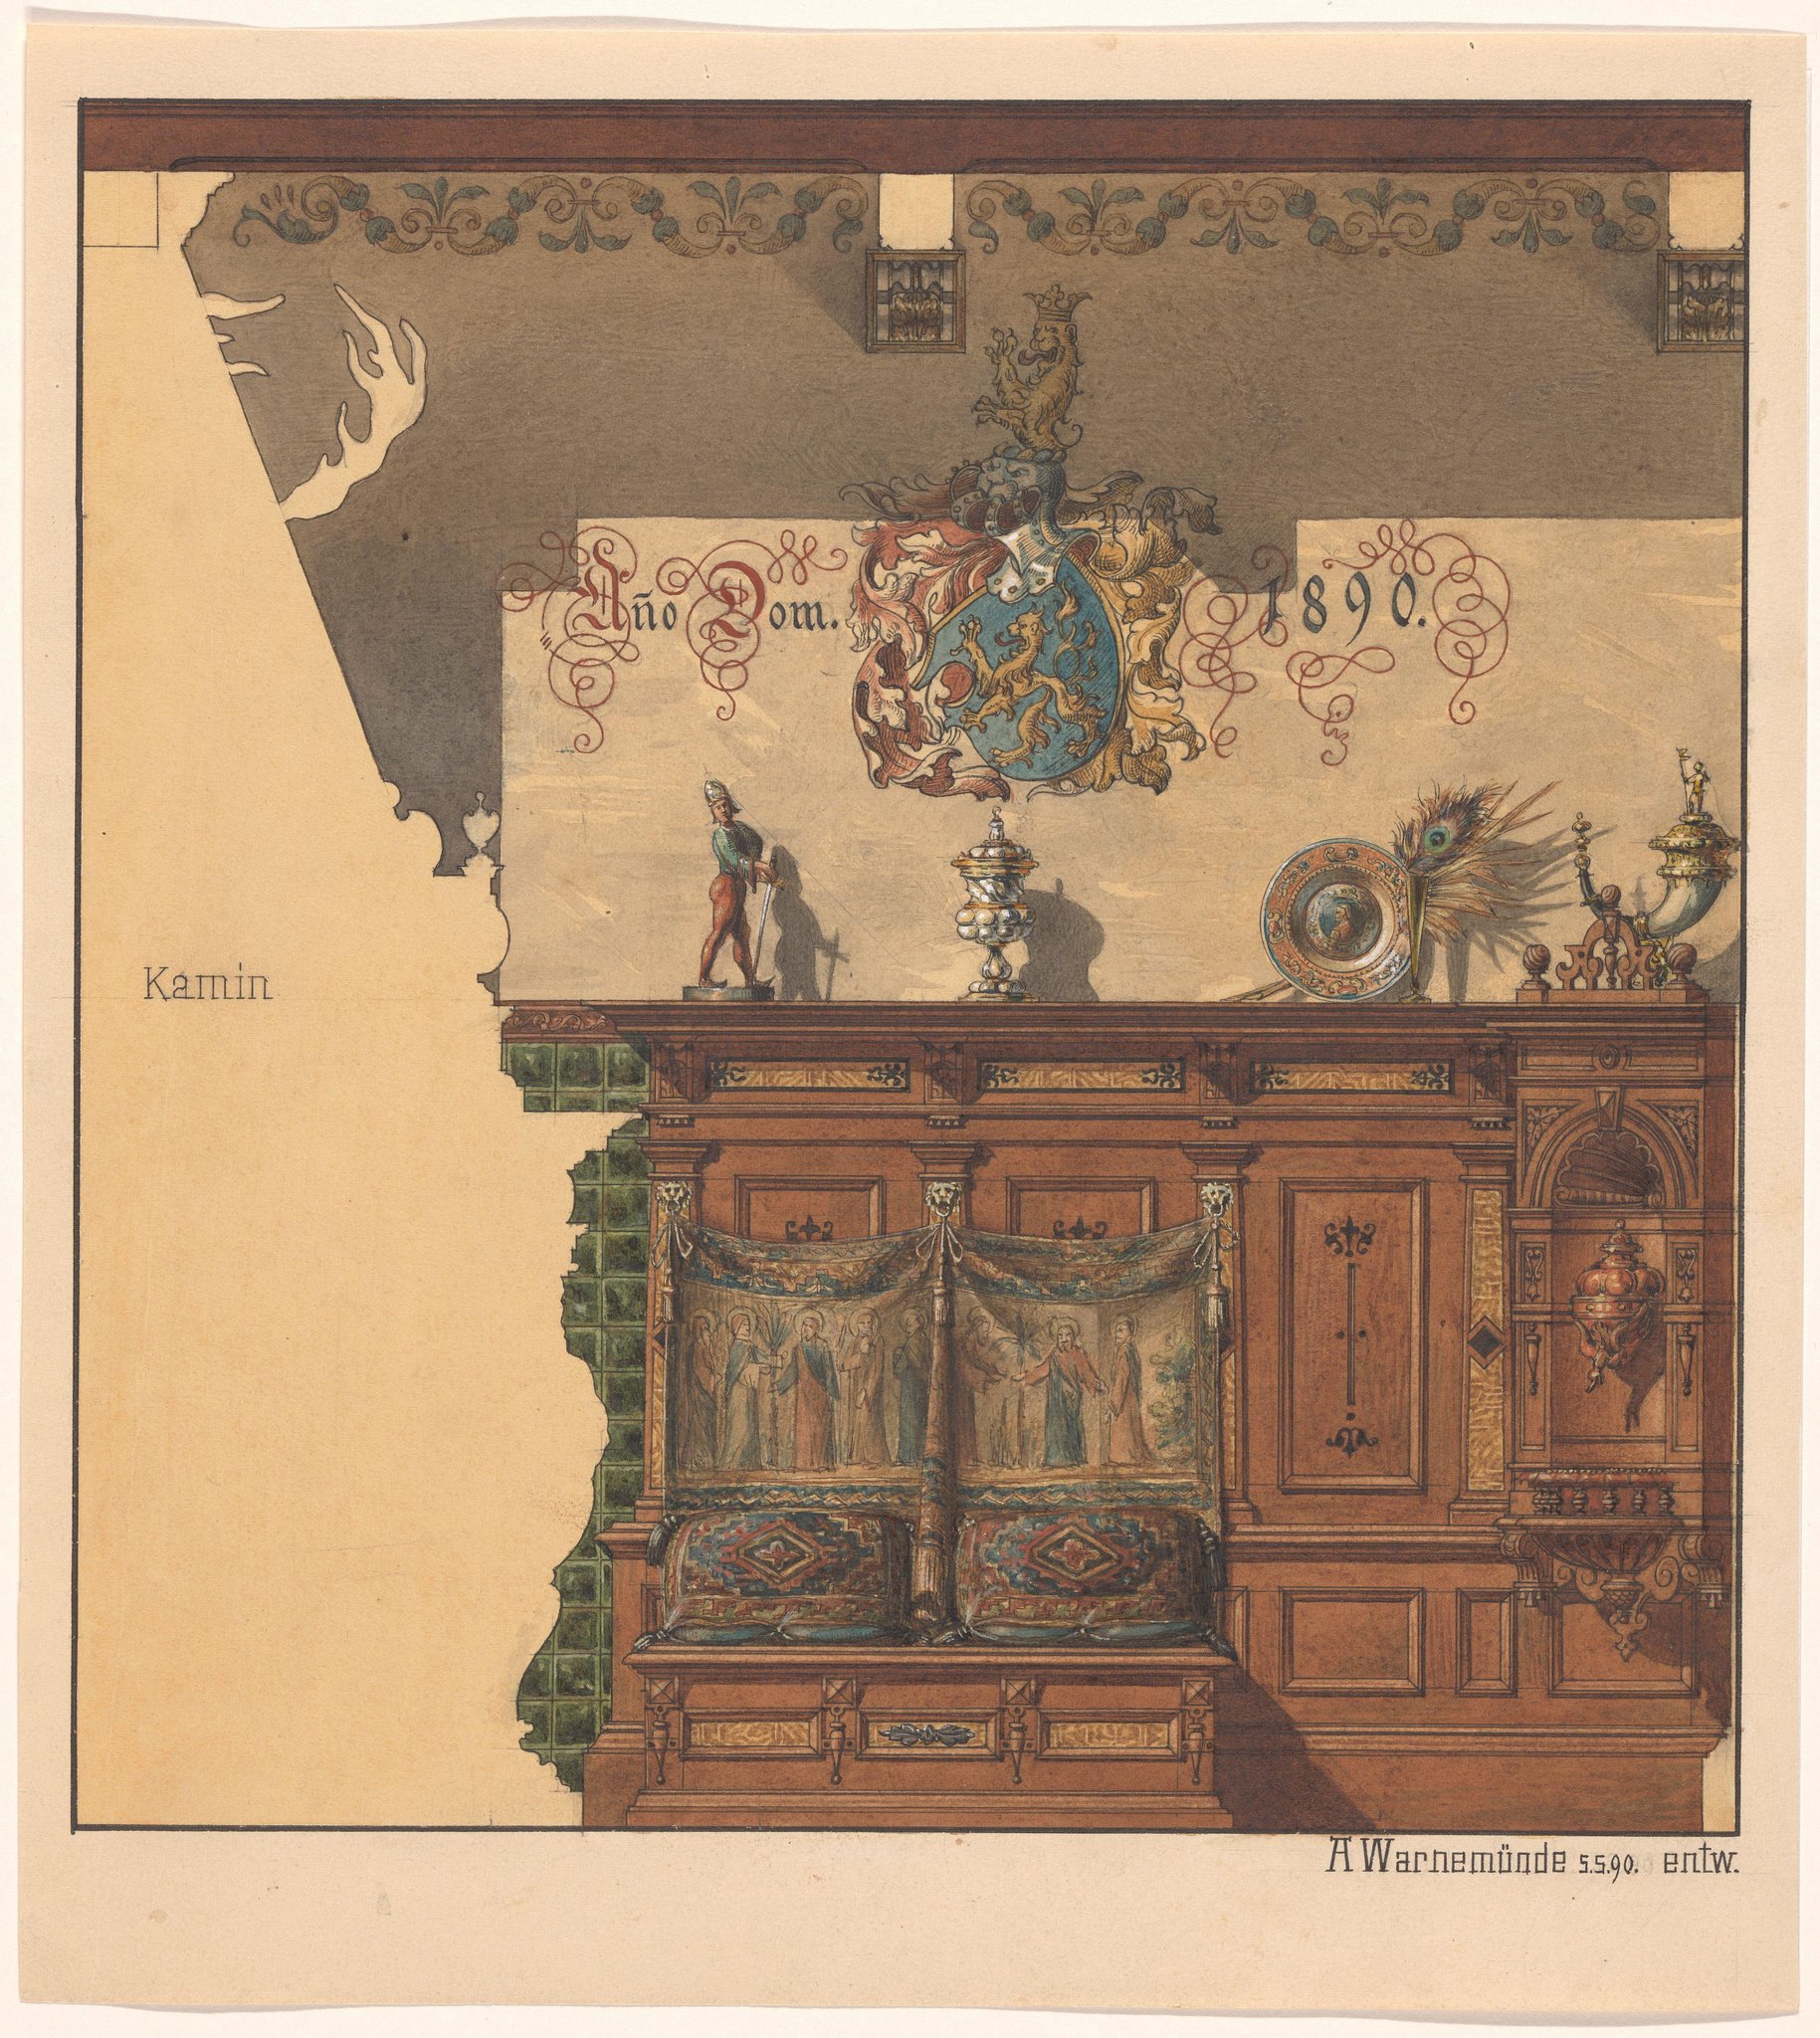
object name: drawing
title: Een kamerwand in Renaissance-stijl, met een bank en een wandfontein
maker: a. warnemünde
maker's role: draughtsman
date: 1890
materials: ink, pencil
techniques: aquarelle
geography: germany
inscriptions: inscription: ‘Anno Dom. 1890’, signature and date: ‘A. Warnemünde 5.5.90. entw.’, inscription: ‘Kamin’